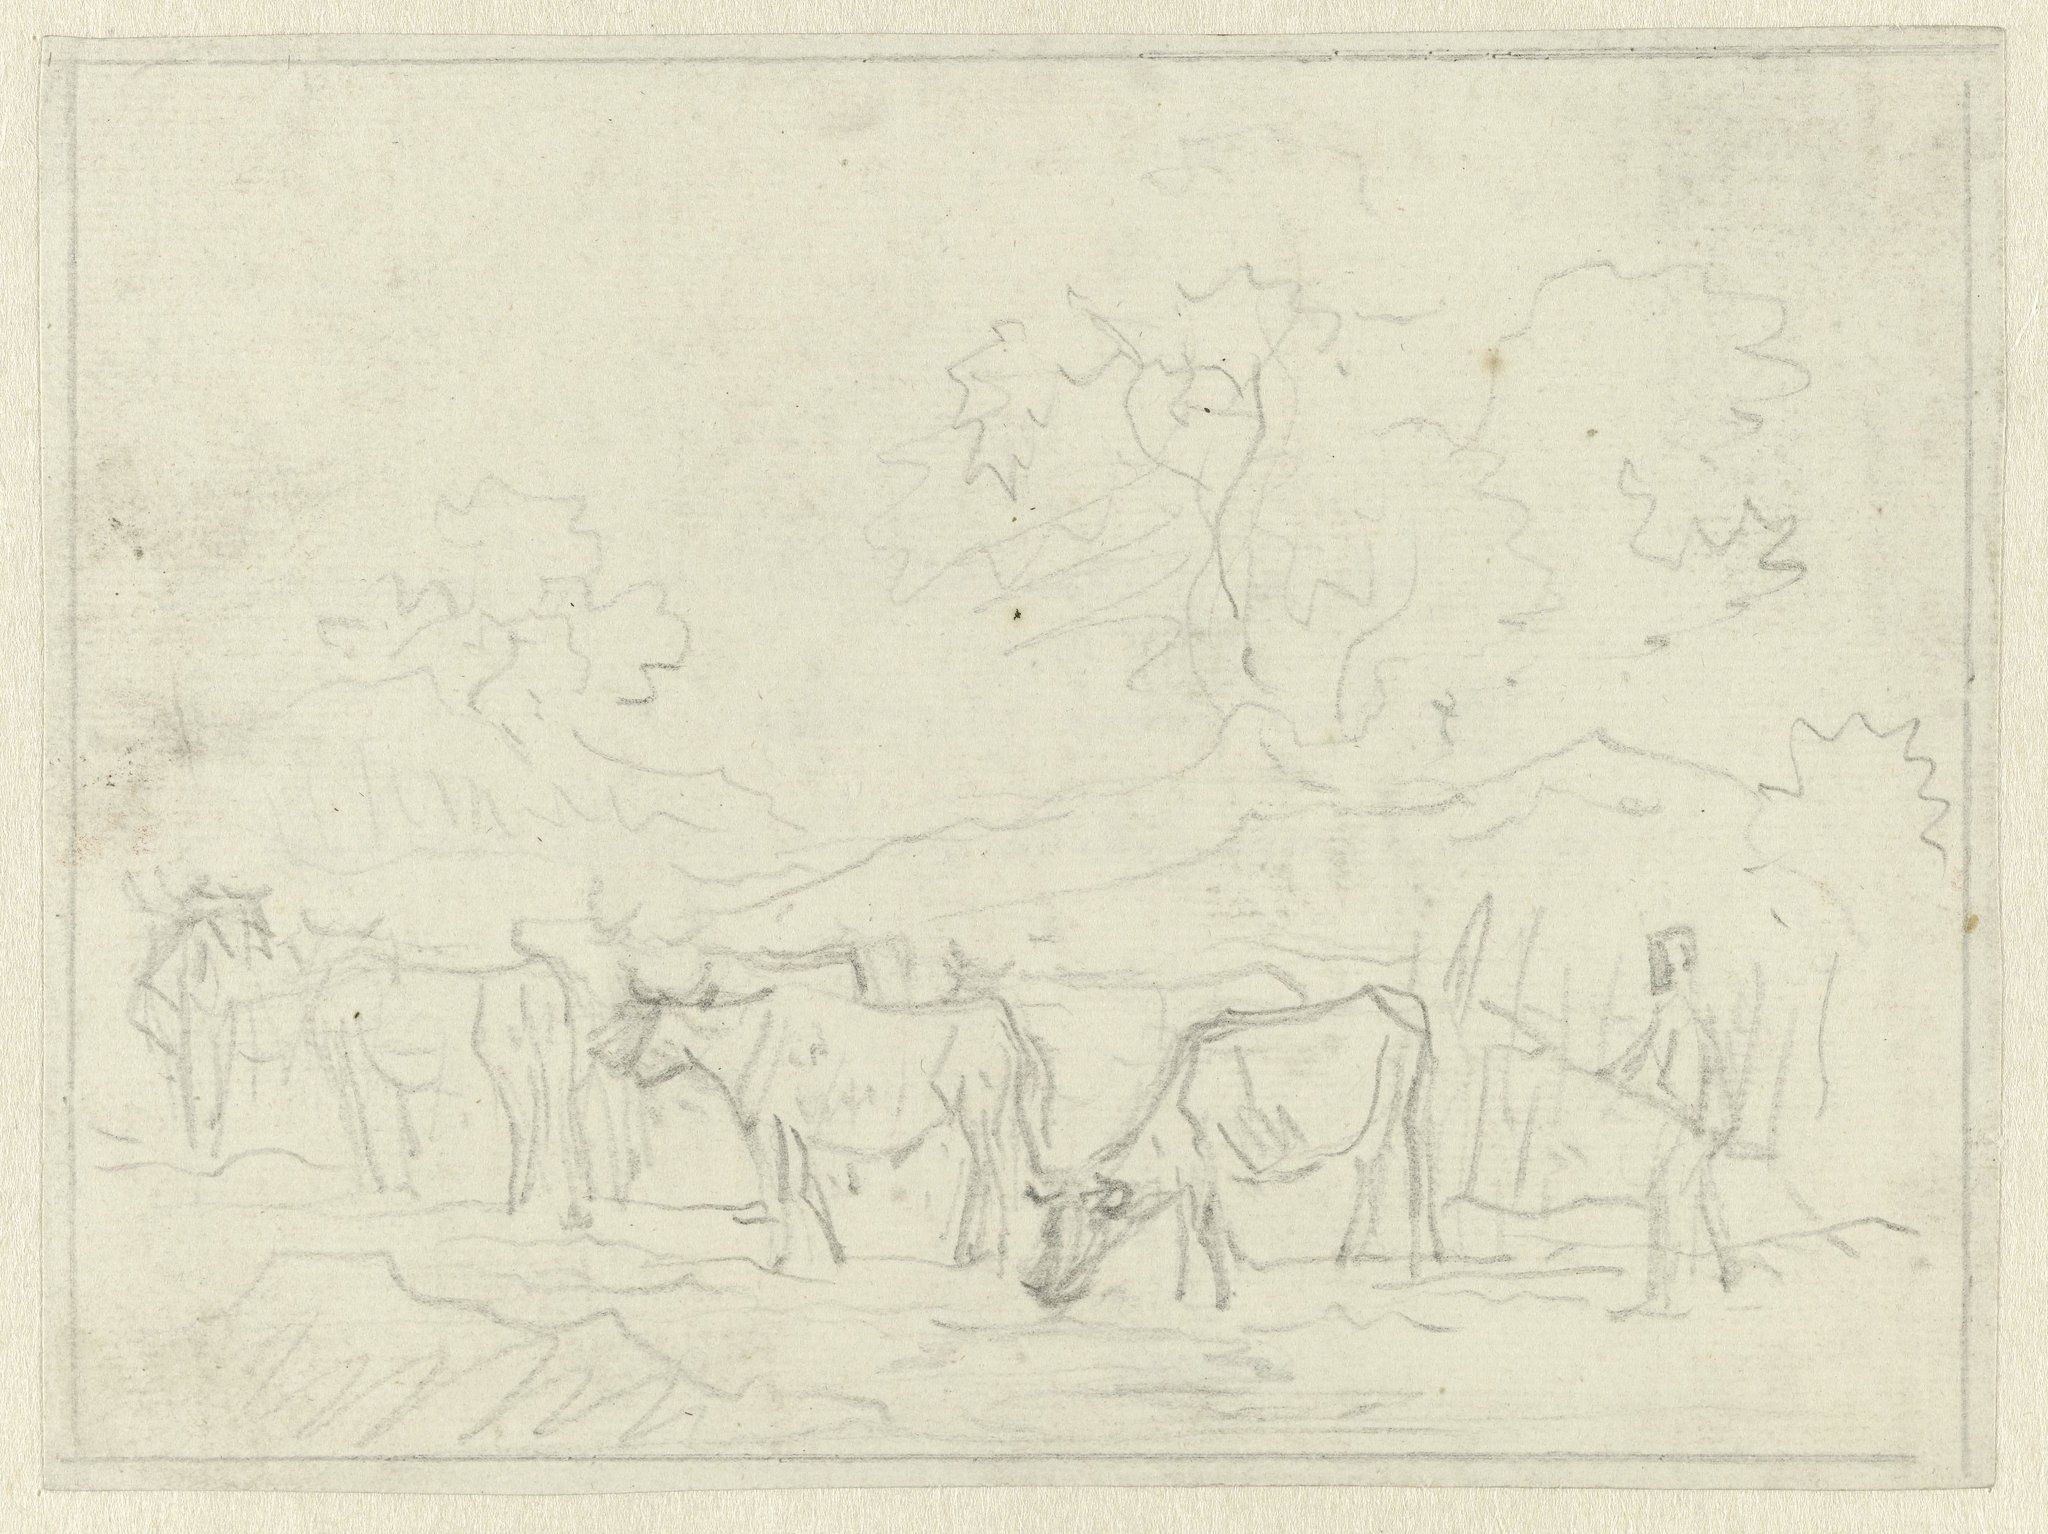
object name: drawing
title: Schets van een Ossendrift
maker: jurriaan andriessen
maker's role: draughtsman, painter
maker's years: 1742-1819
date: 1752-1819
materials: graphite, paper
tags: drawing, sketch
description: Schets naar een voortekening van de "Ossendrift" door Paulus Potter.